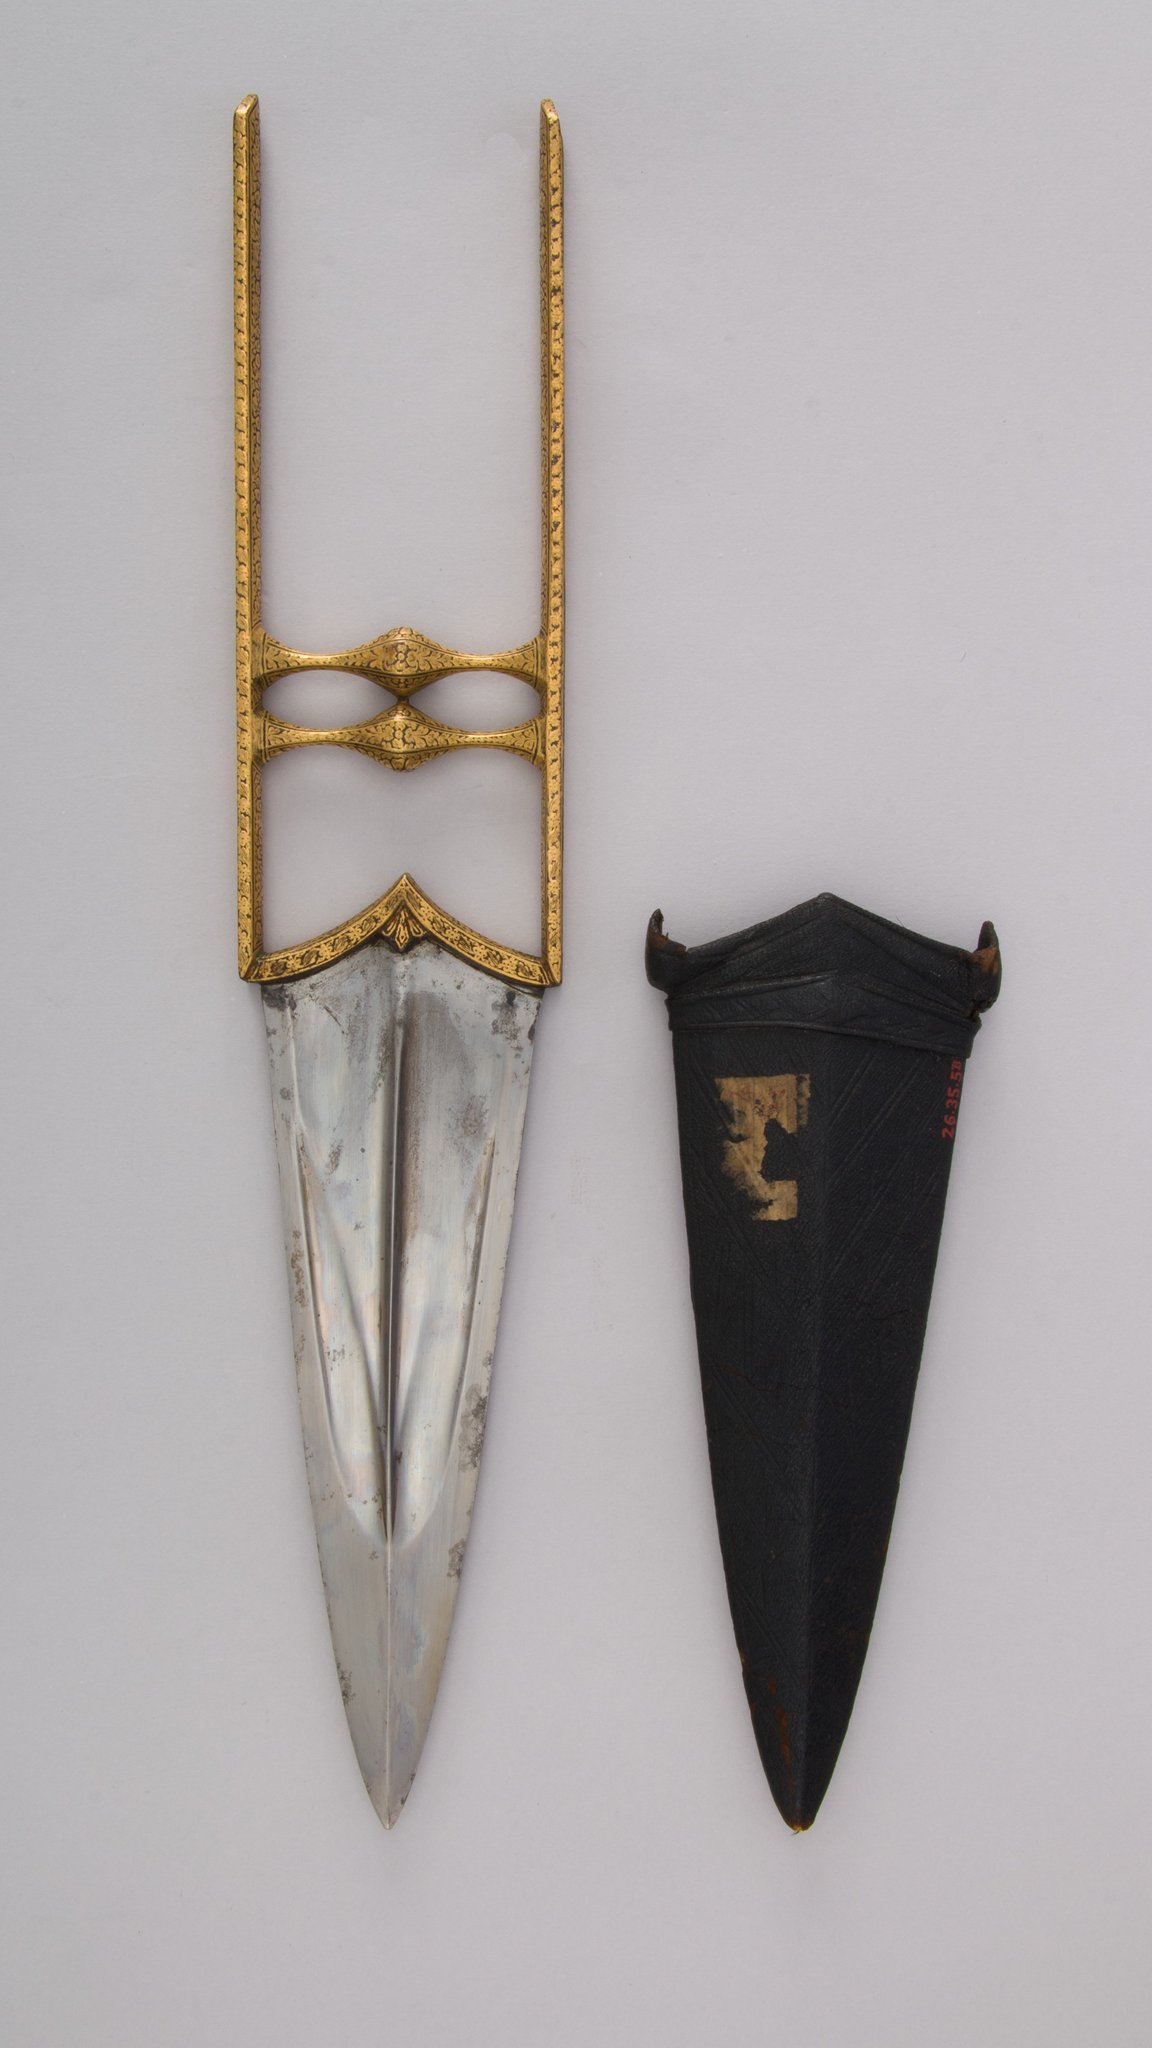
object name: dagger with sheath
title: Dagger (Katar) with Sheath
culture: indian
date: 1701-1900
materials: gold, leather, steel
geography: india